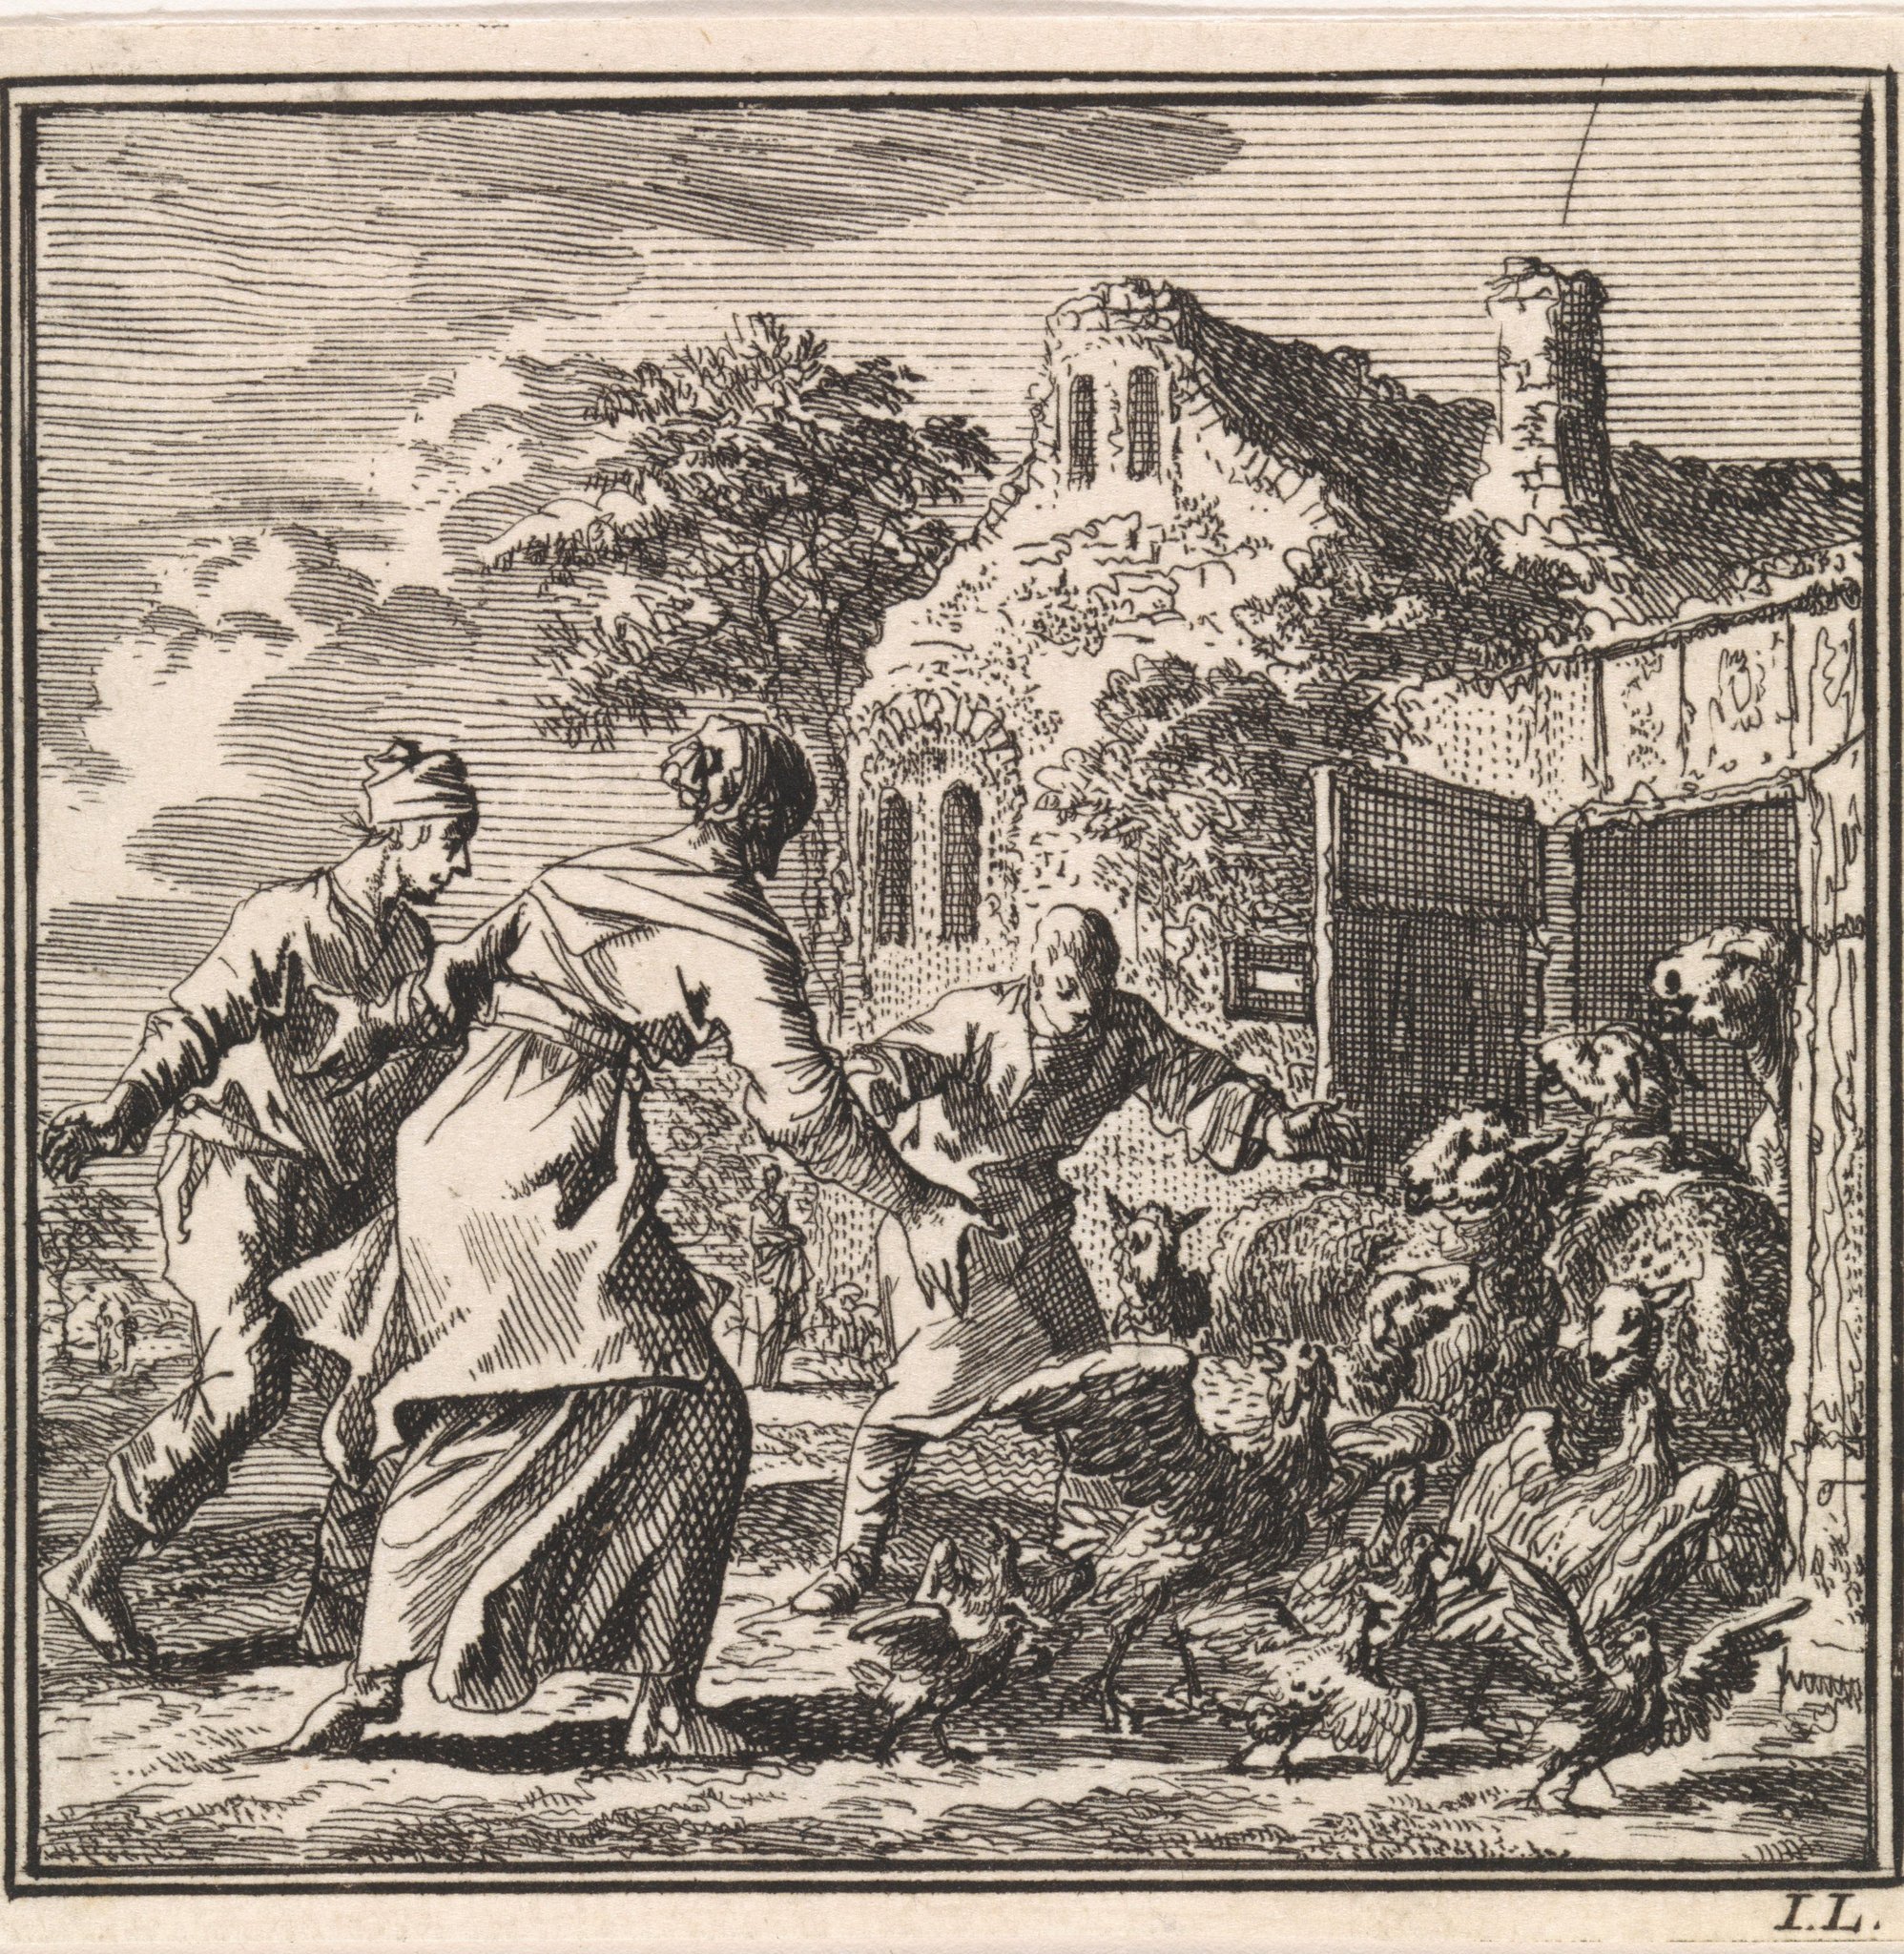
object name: book illustration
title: Het Vee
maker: jan luyken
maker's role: draughtsman, print maker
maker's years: 1649-1712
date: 1711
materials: paper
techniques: etching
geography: amsterdam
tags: cattle, cattle driving, cattle driver, stall, stable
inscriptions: collector's mark: Lugt 2228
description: Illustratie voor: Luyken, Jan. De Bykorf des Gemoeds. Amsterdam: Pieter Arentsz. II (wed.) en Cornelis van der Sys, 1711, p. 126.